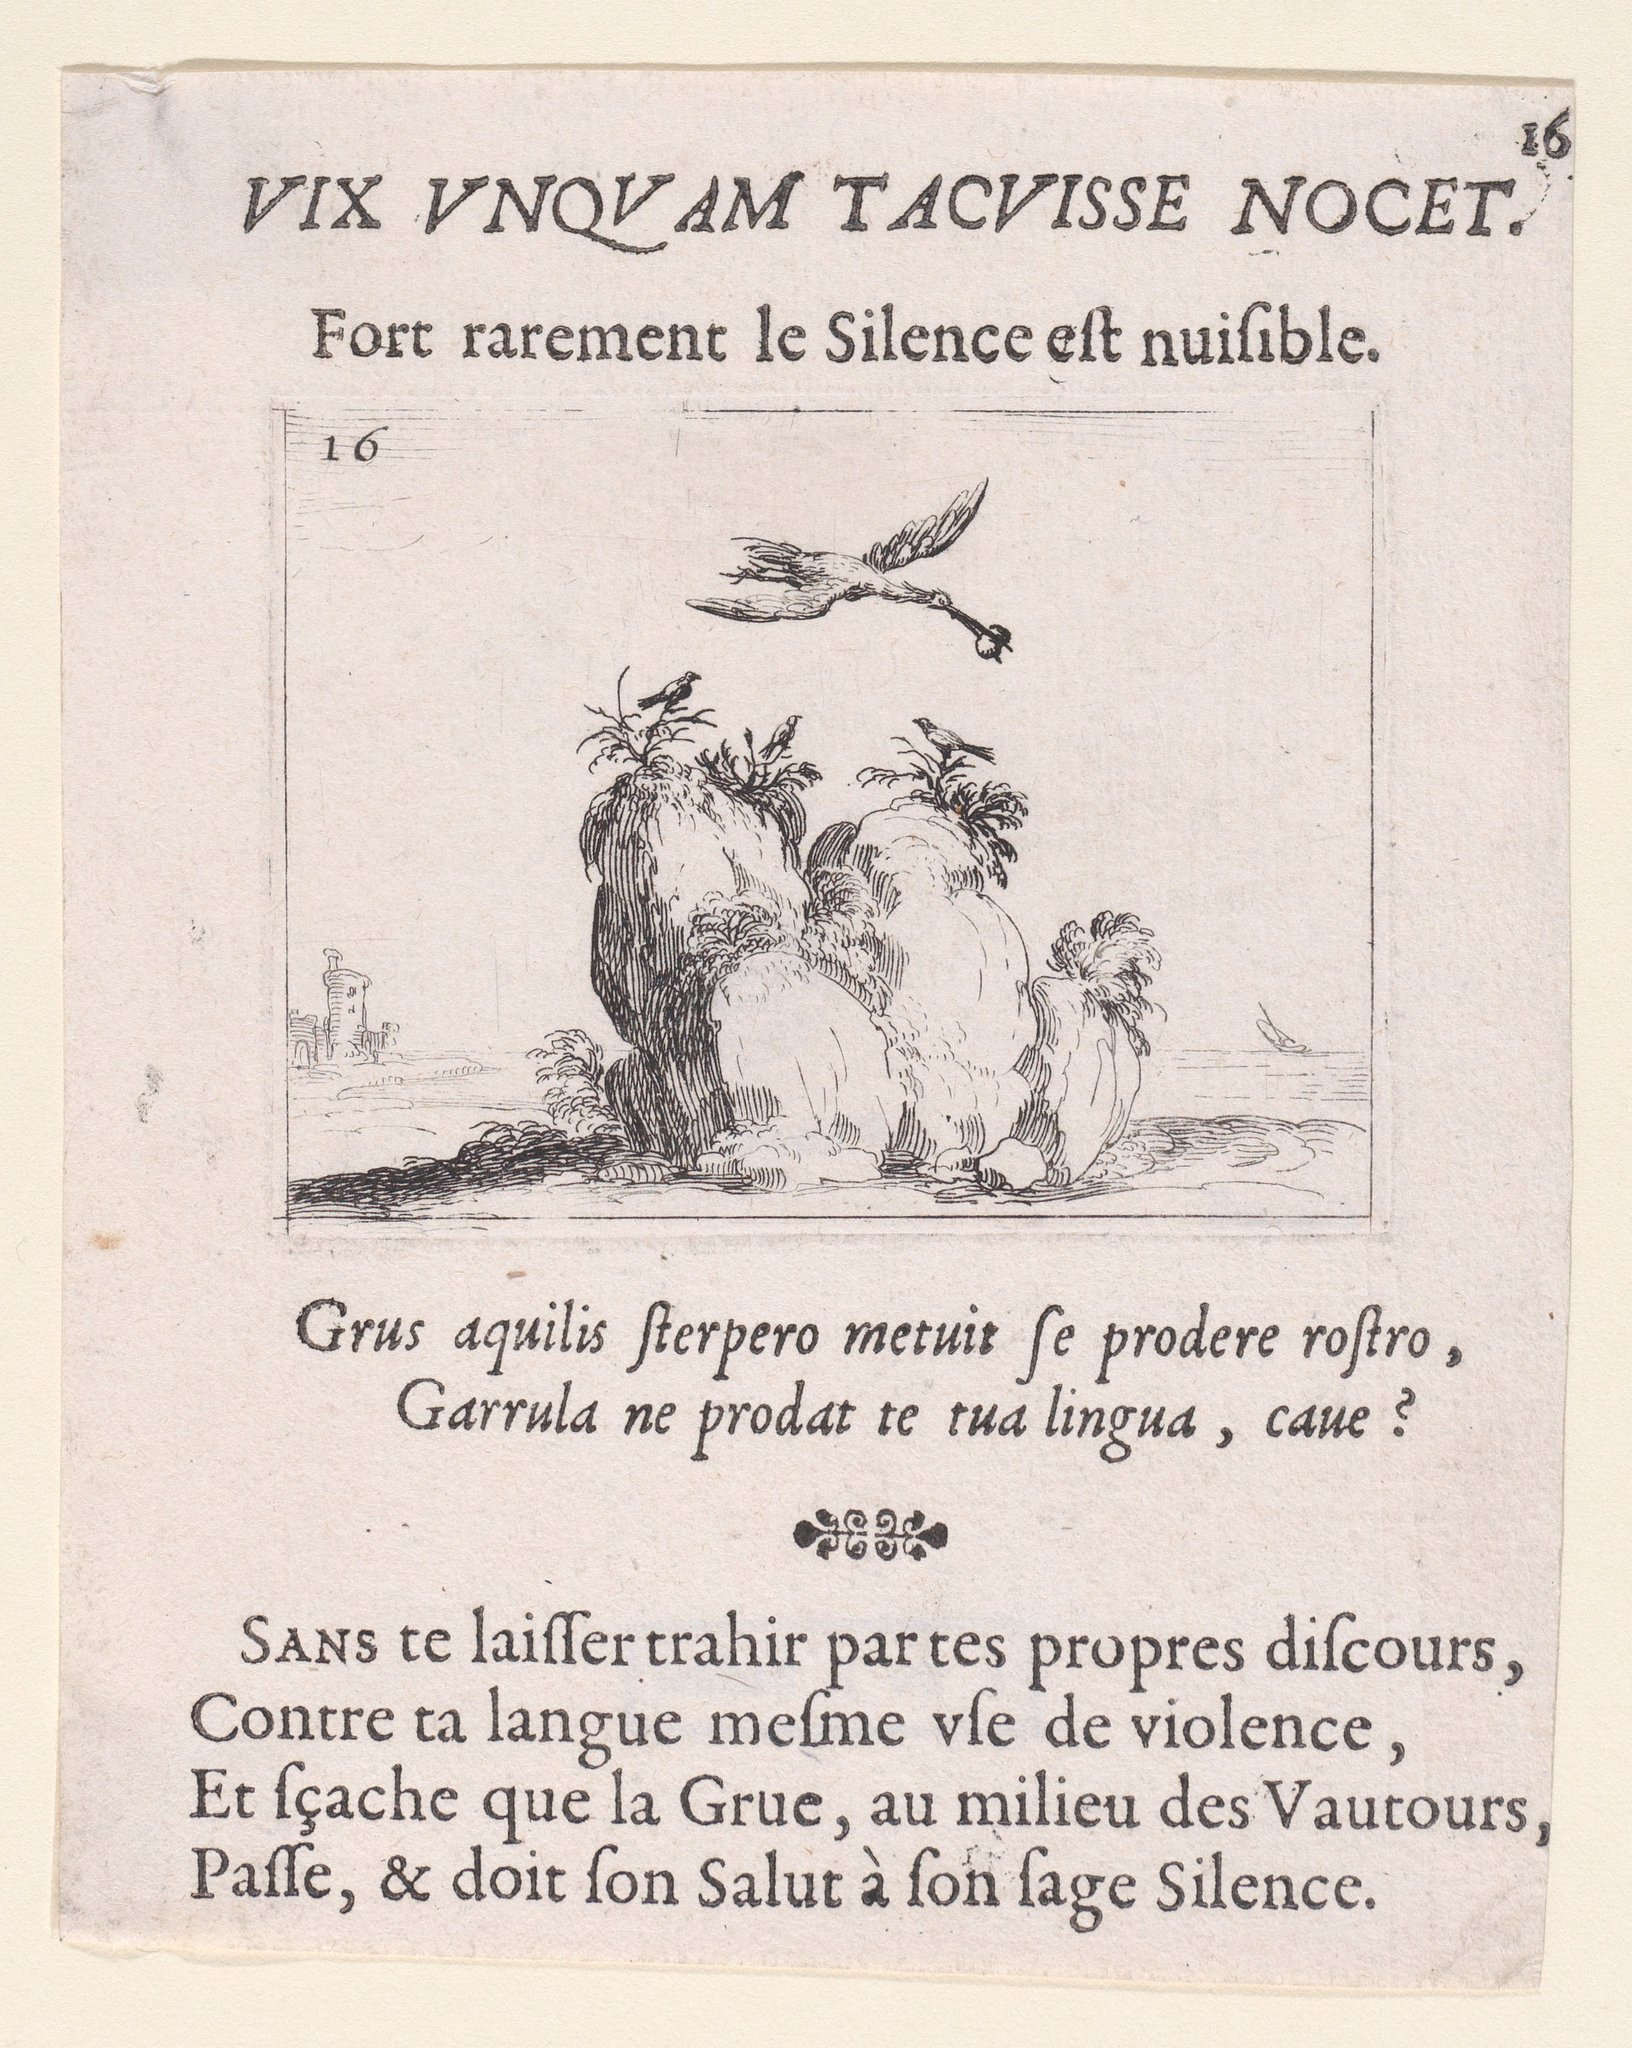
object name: print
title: Une Grue Volant (A Flying Crane), plate 16 from "Lux Claustri ou La Lumière du Cloitre" (The Light of the Cloisters)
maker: jacques callot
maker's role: artist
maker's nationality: french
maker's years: 1592-1635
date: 1621-1635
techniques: etching